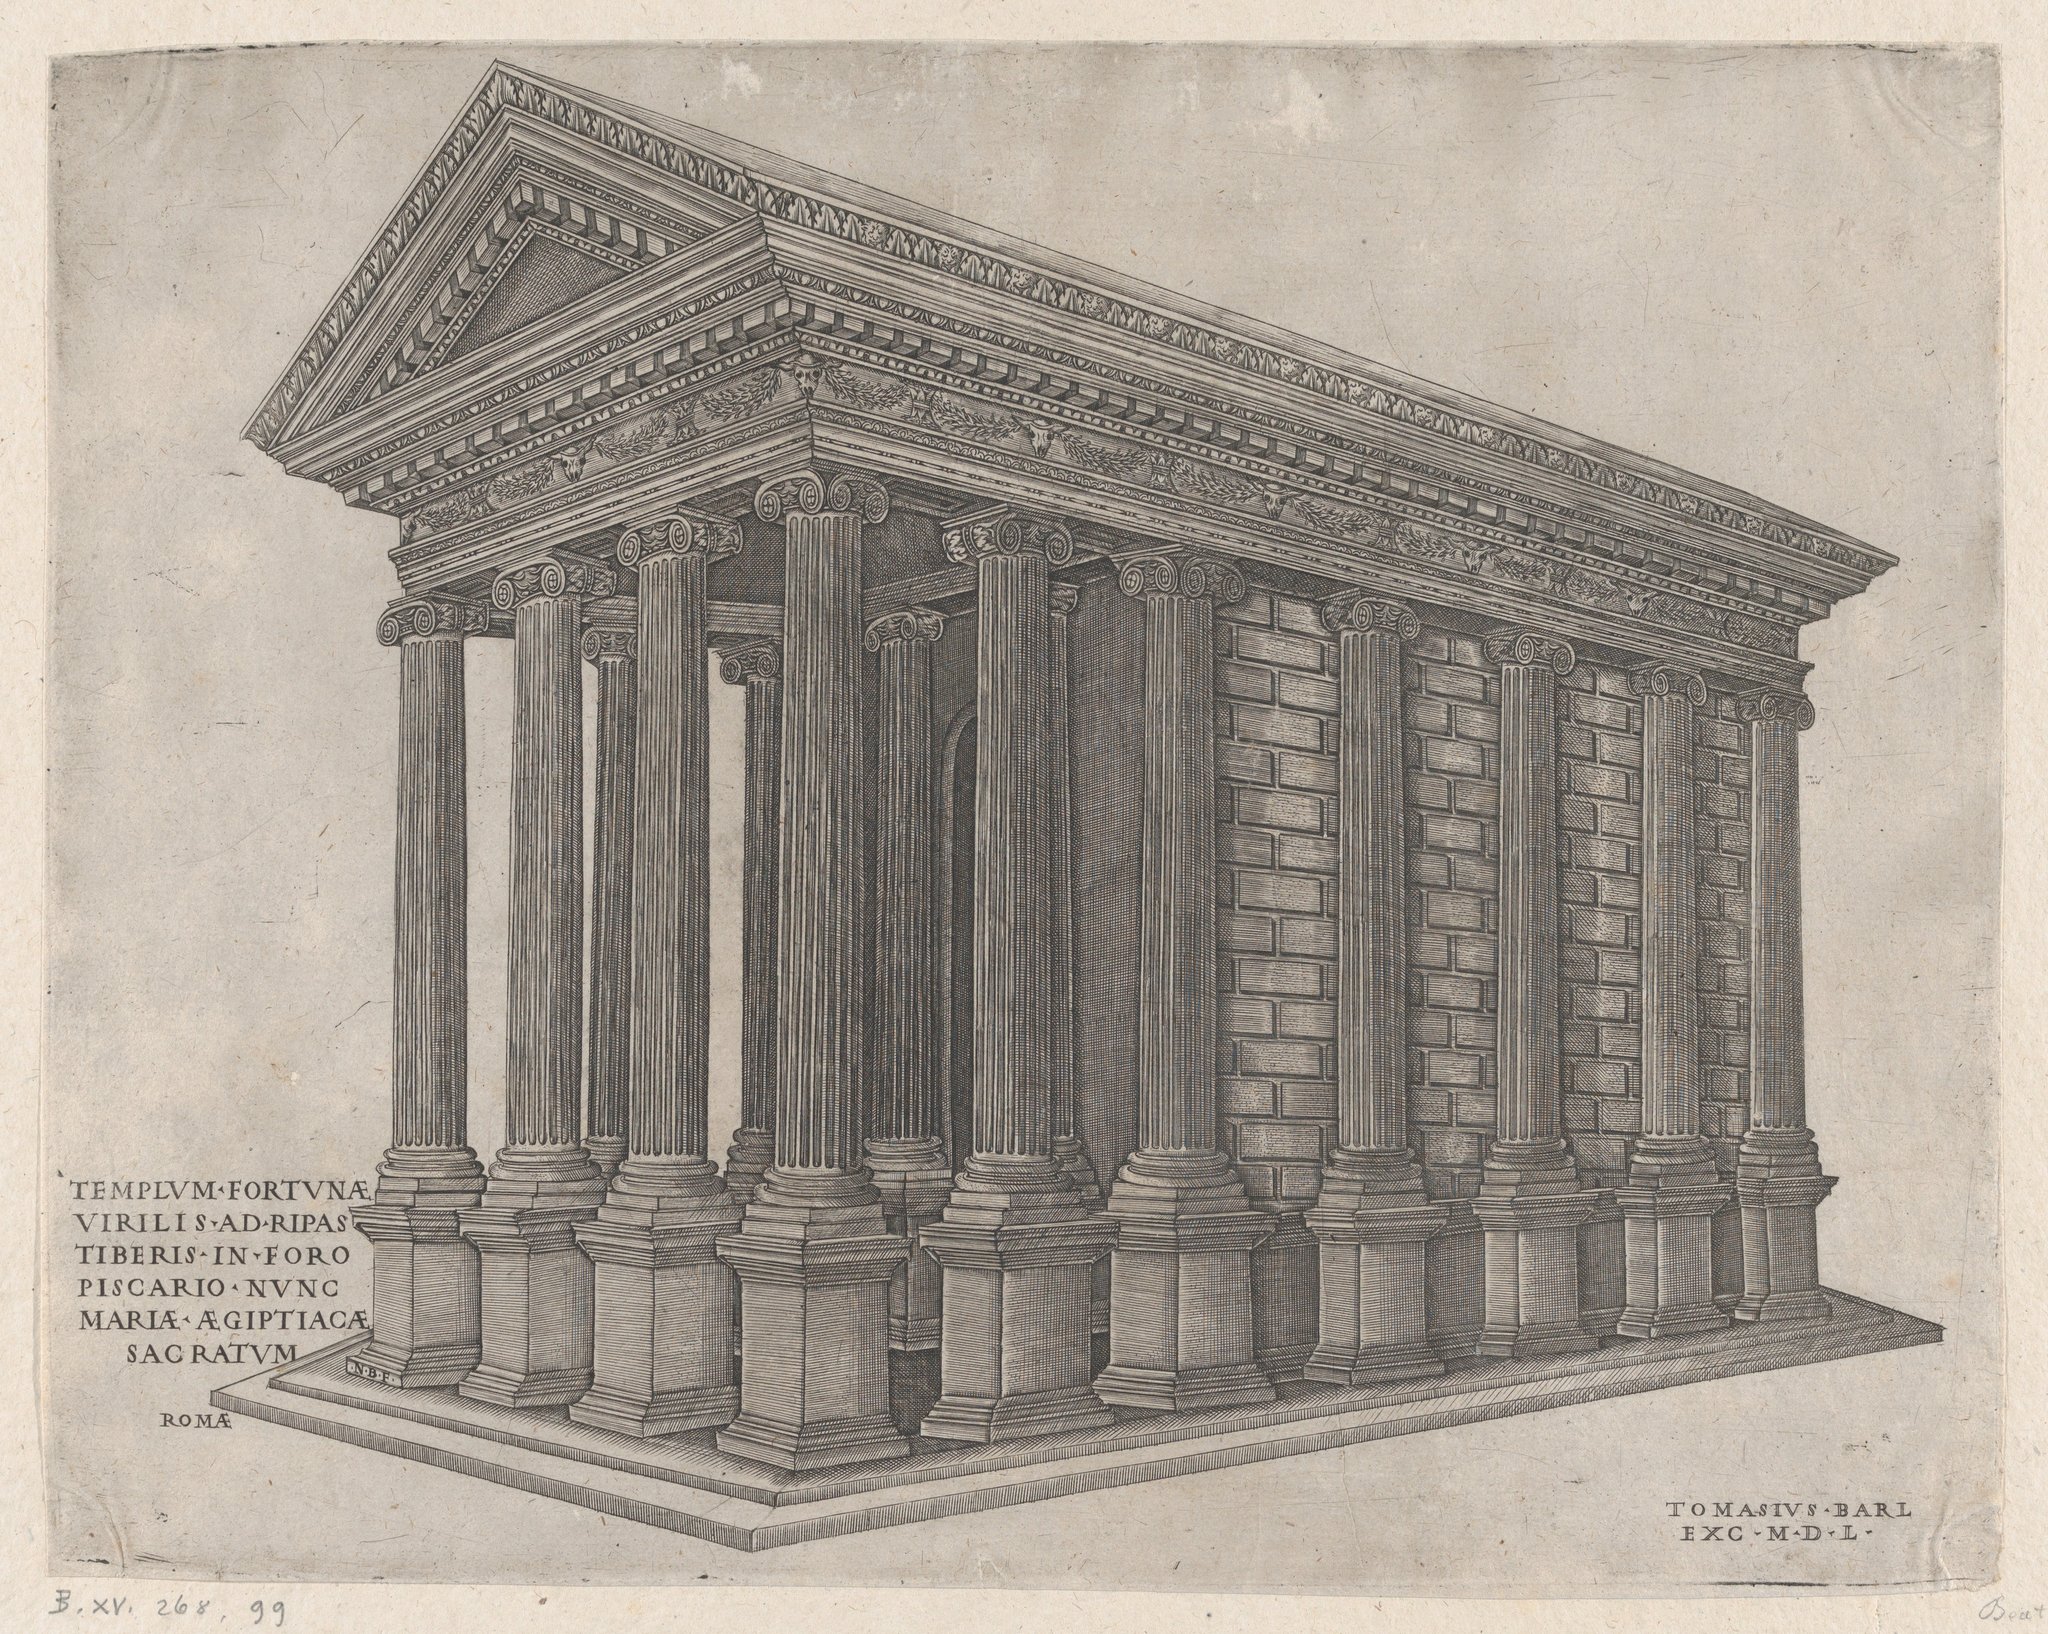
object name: print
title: Temple of Fortuna, Rome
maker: nicolas beatrizet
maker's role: artist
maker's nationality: french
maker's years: 1515-1566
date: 1550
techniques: engraving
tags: architecture,temples